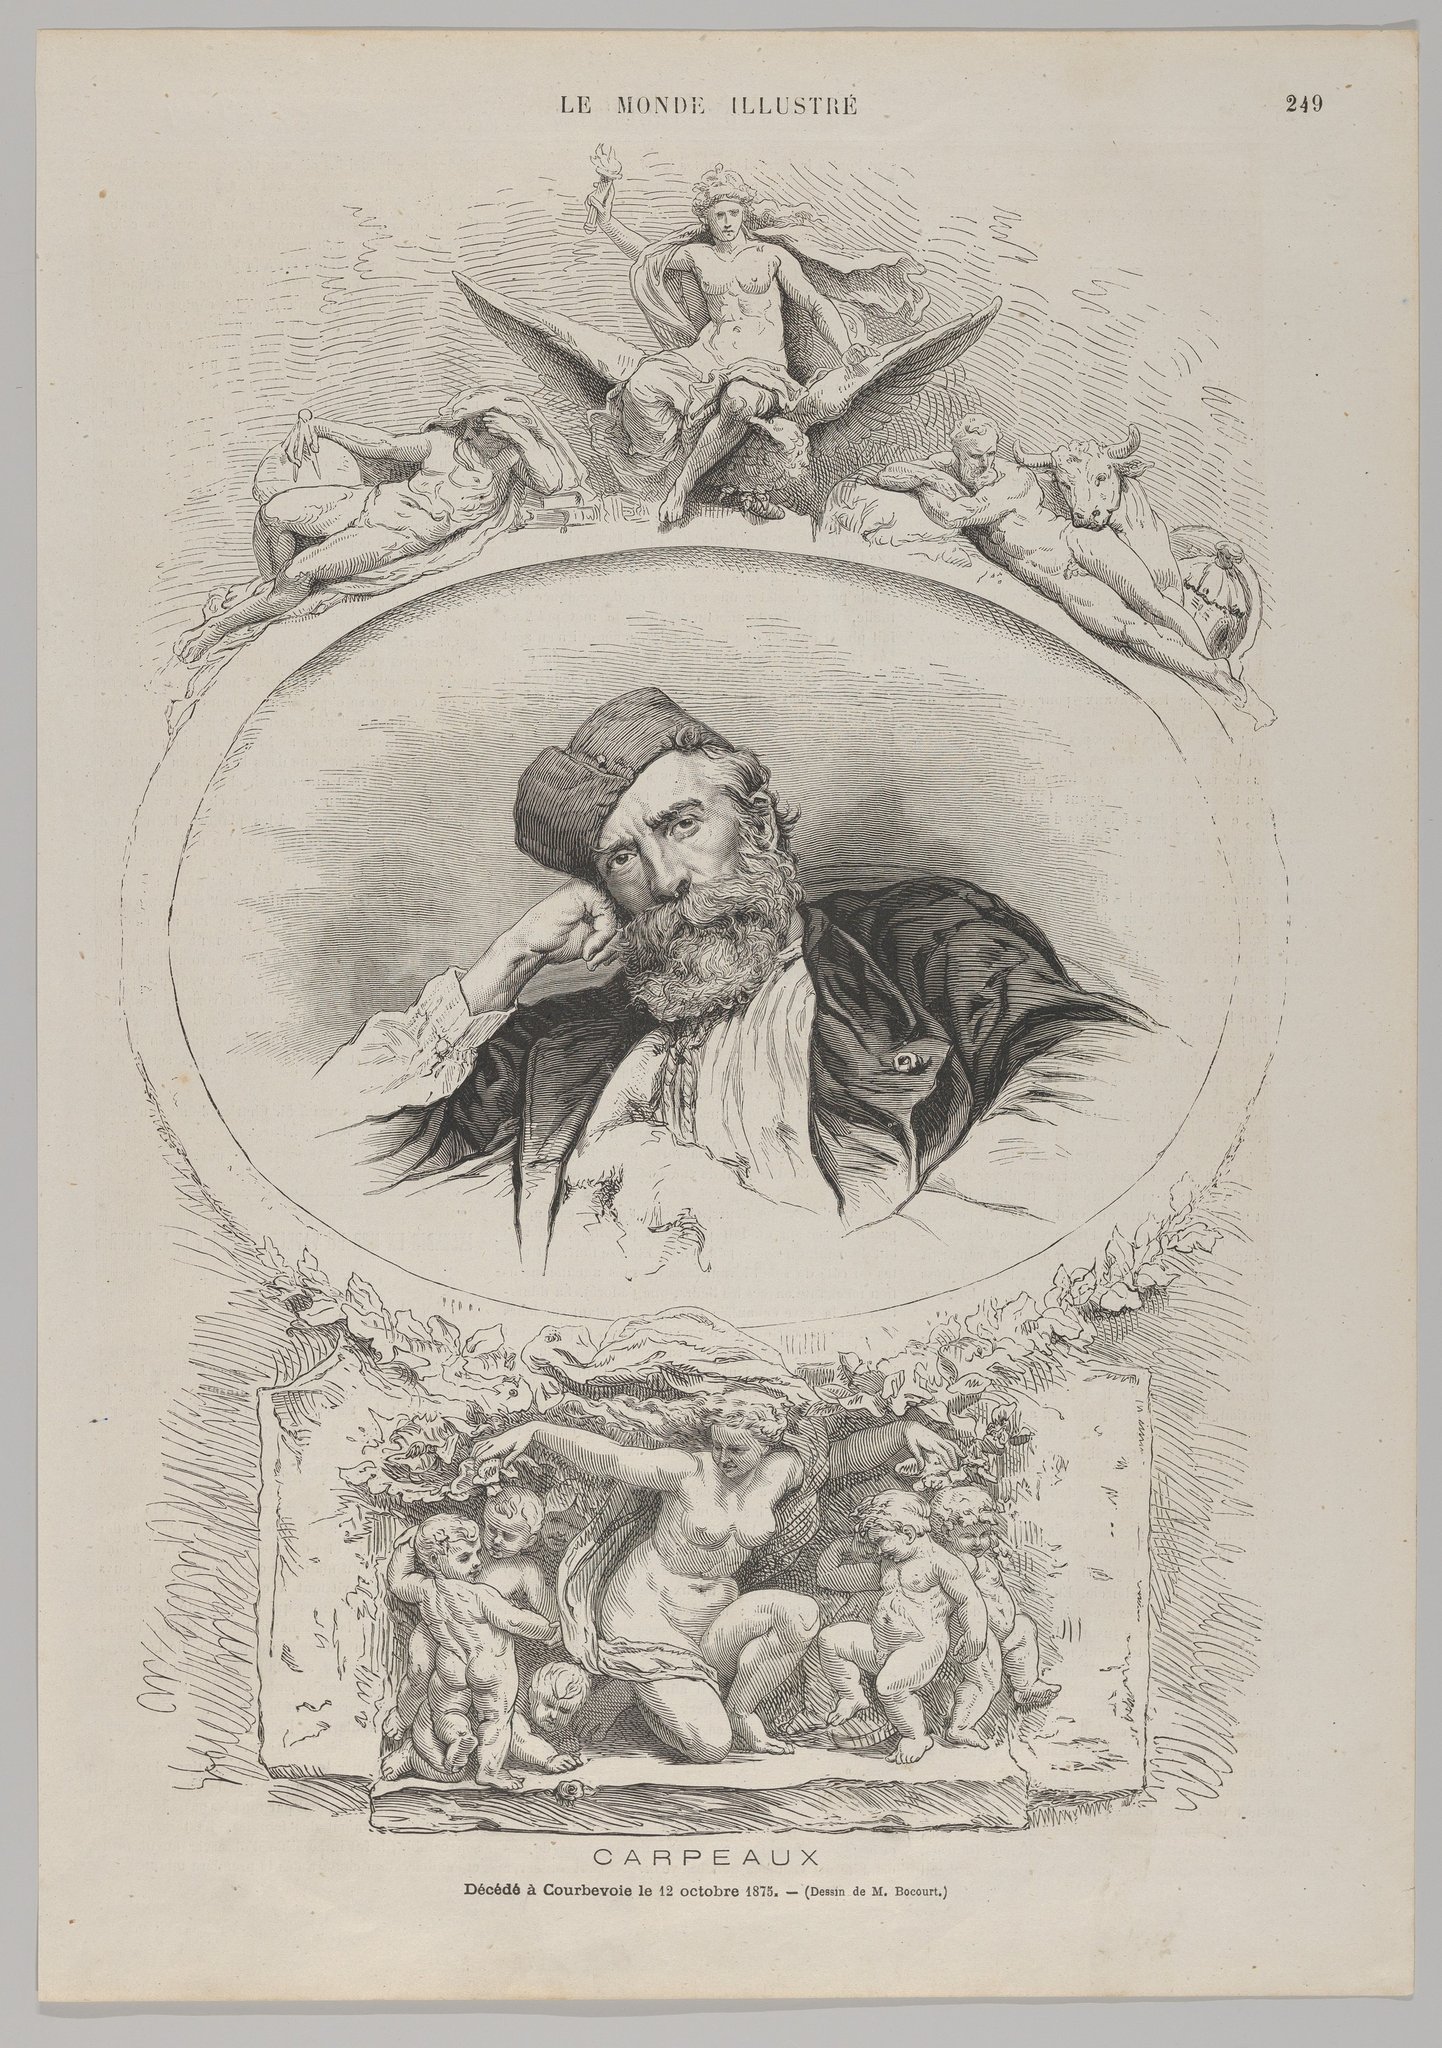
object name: print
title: Portrait of Jean-Baptiste Carpeaux, from "Le Monde Illustré"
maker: anonymous, french, 19th century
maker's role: engraver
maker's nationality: french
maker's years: 1800-1900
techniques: engraving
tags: children,men,male nudes,portraits,female nudes